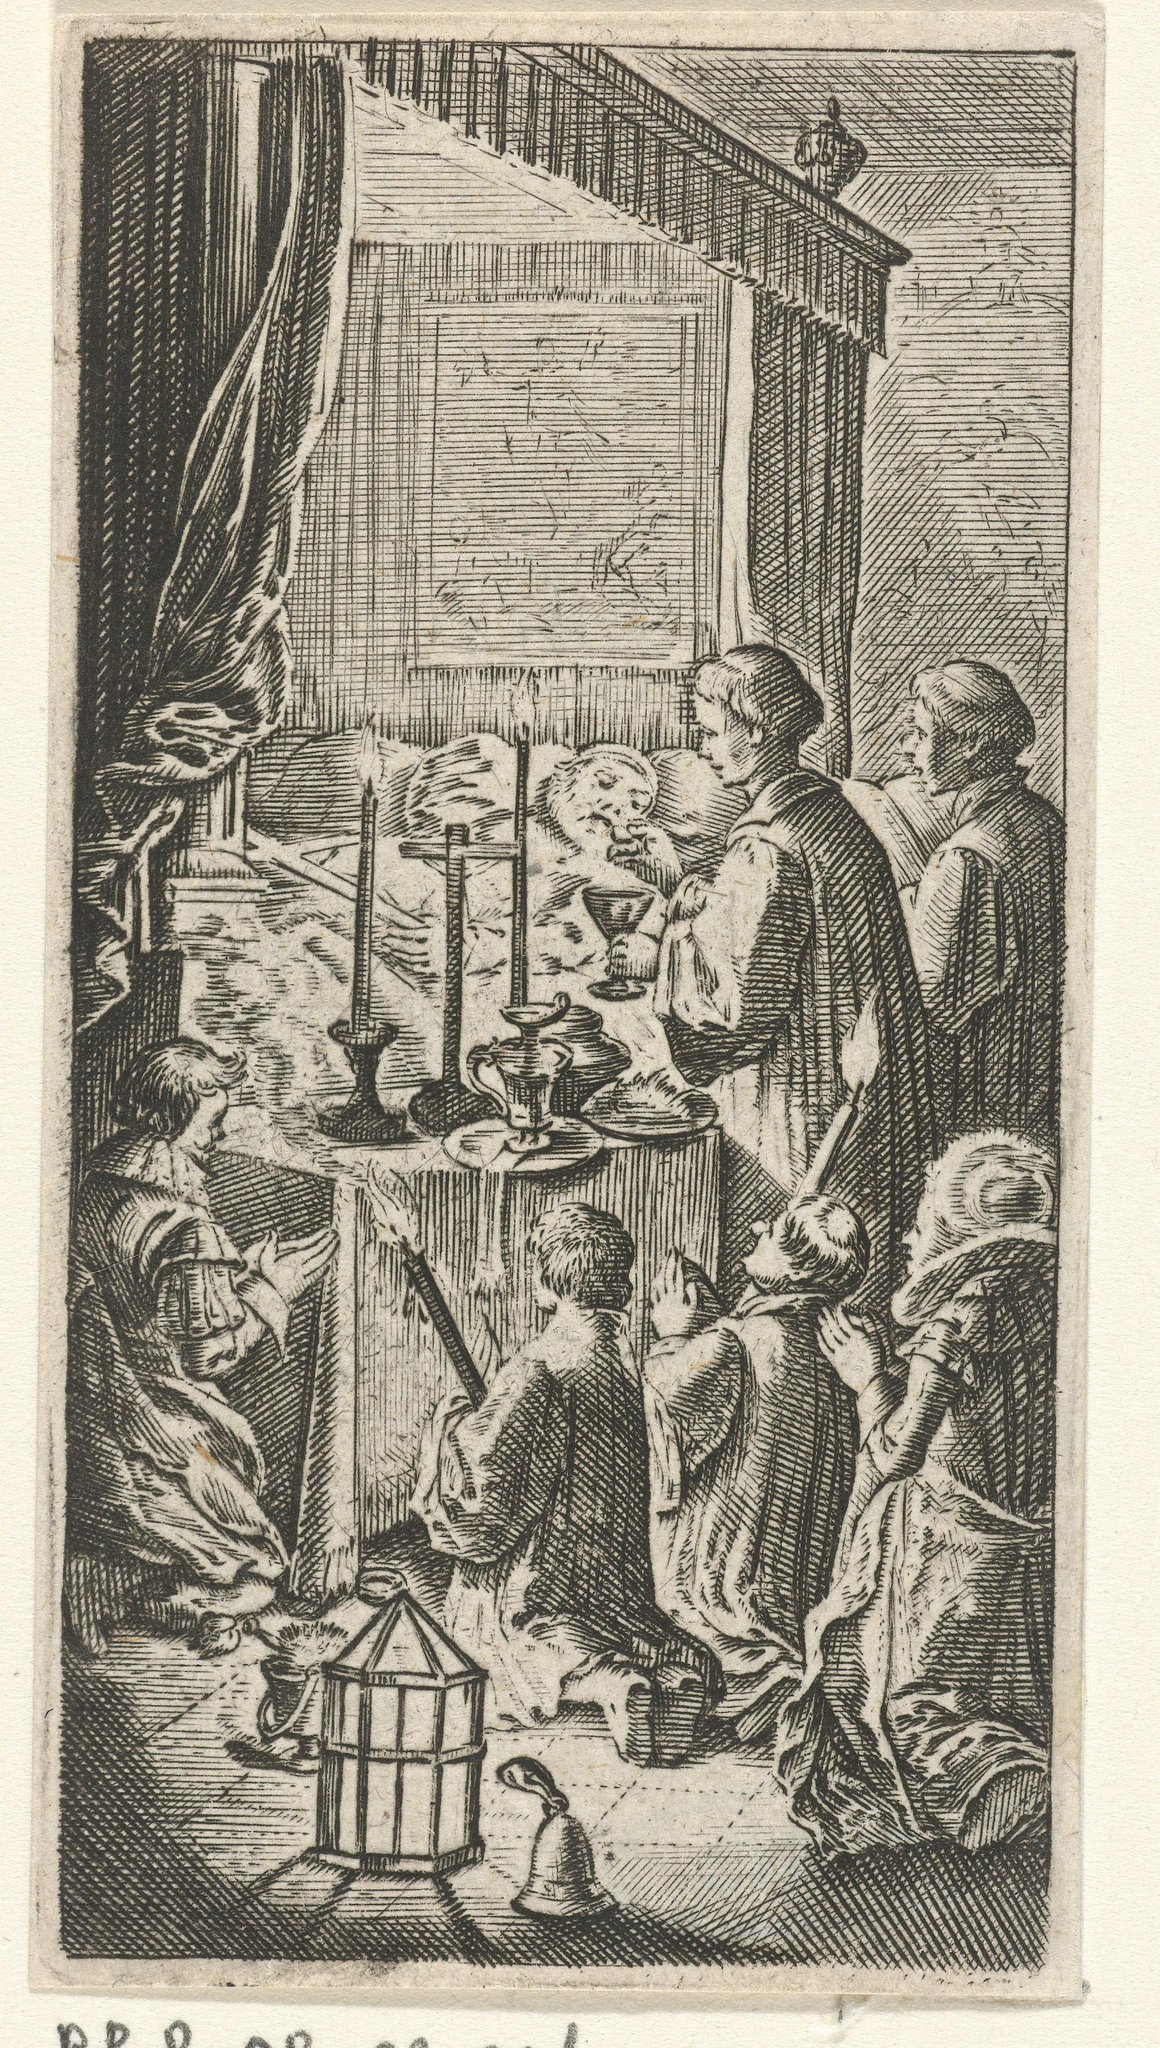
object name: print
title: Sacrament van de stervende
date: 1626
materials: paper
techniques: engraving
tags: extreme unction ~ the last of the seven sacraments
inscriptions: collector's mark: Lugt 2228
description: Prent vermoedelijk gebruikt in: Bellarmino, Roberto Francesco Romolo. De arte bene moriendi libri dvo. Keulen: Cornelius van Egmondt, 1626.